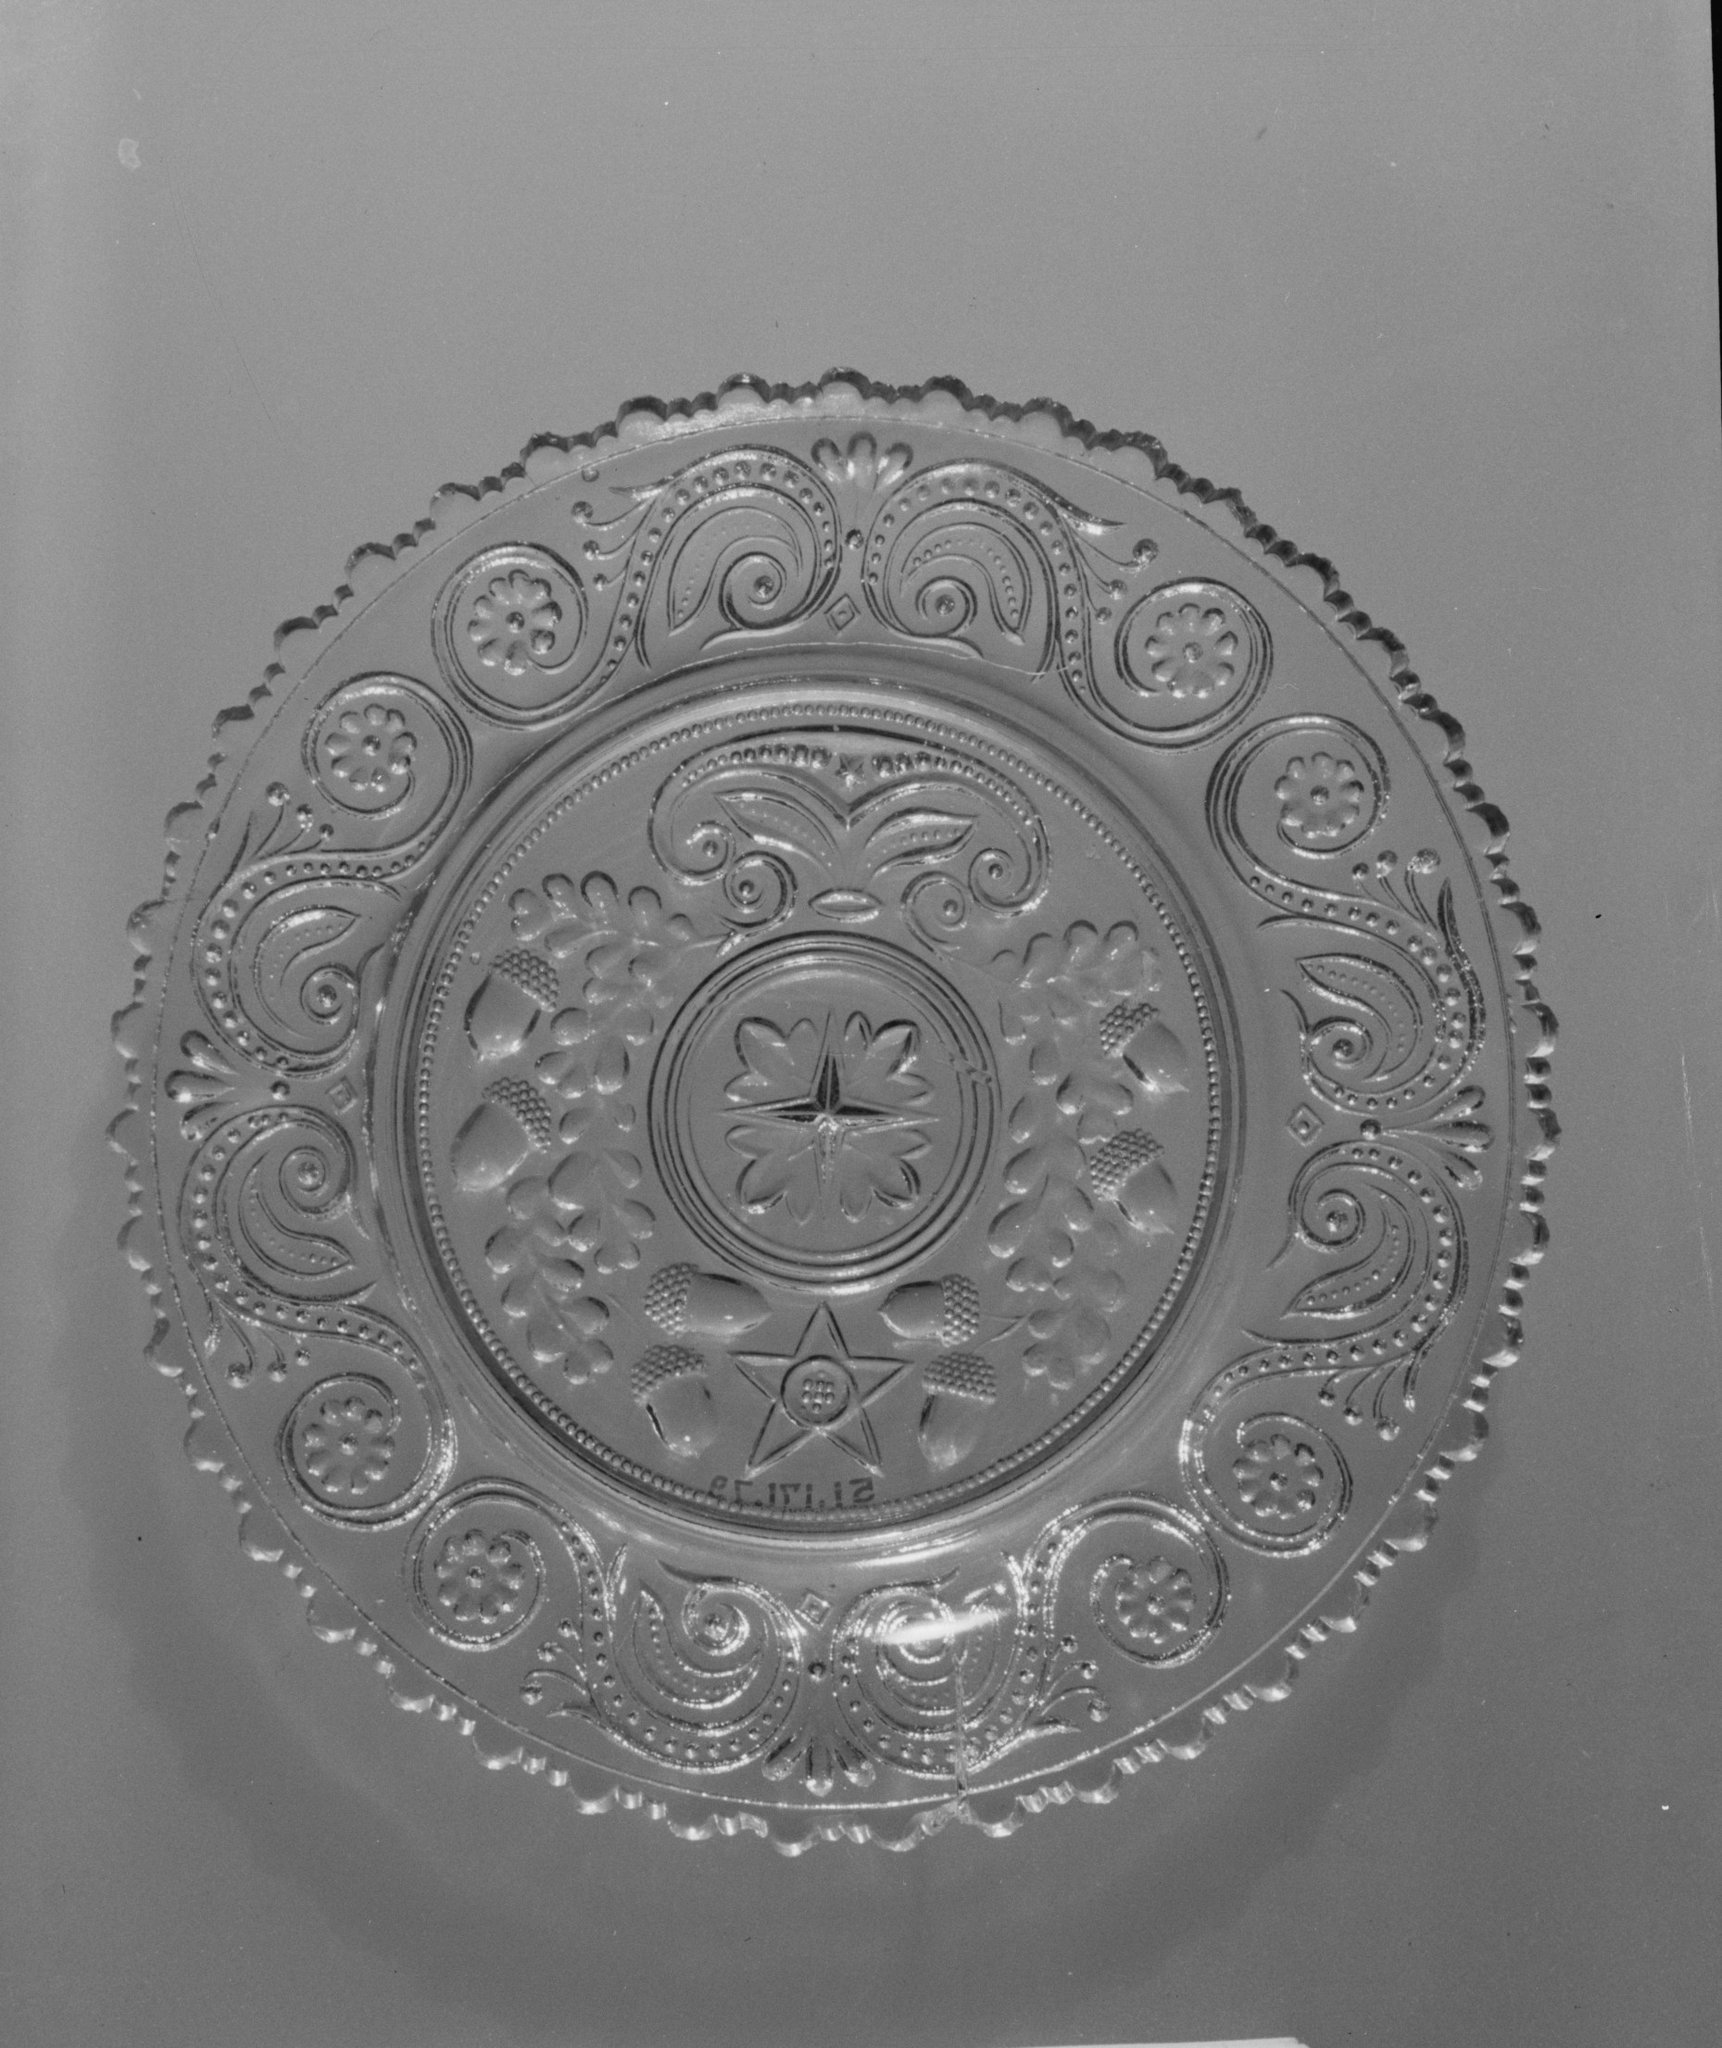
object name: plate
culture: american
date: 1830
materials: glass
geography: united states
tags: acorns